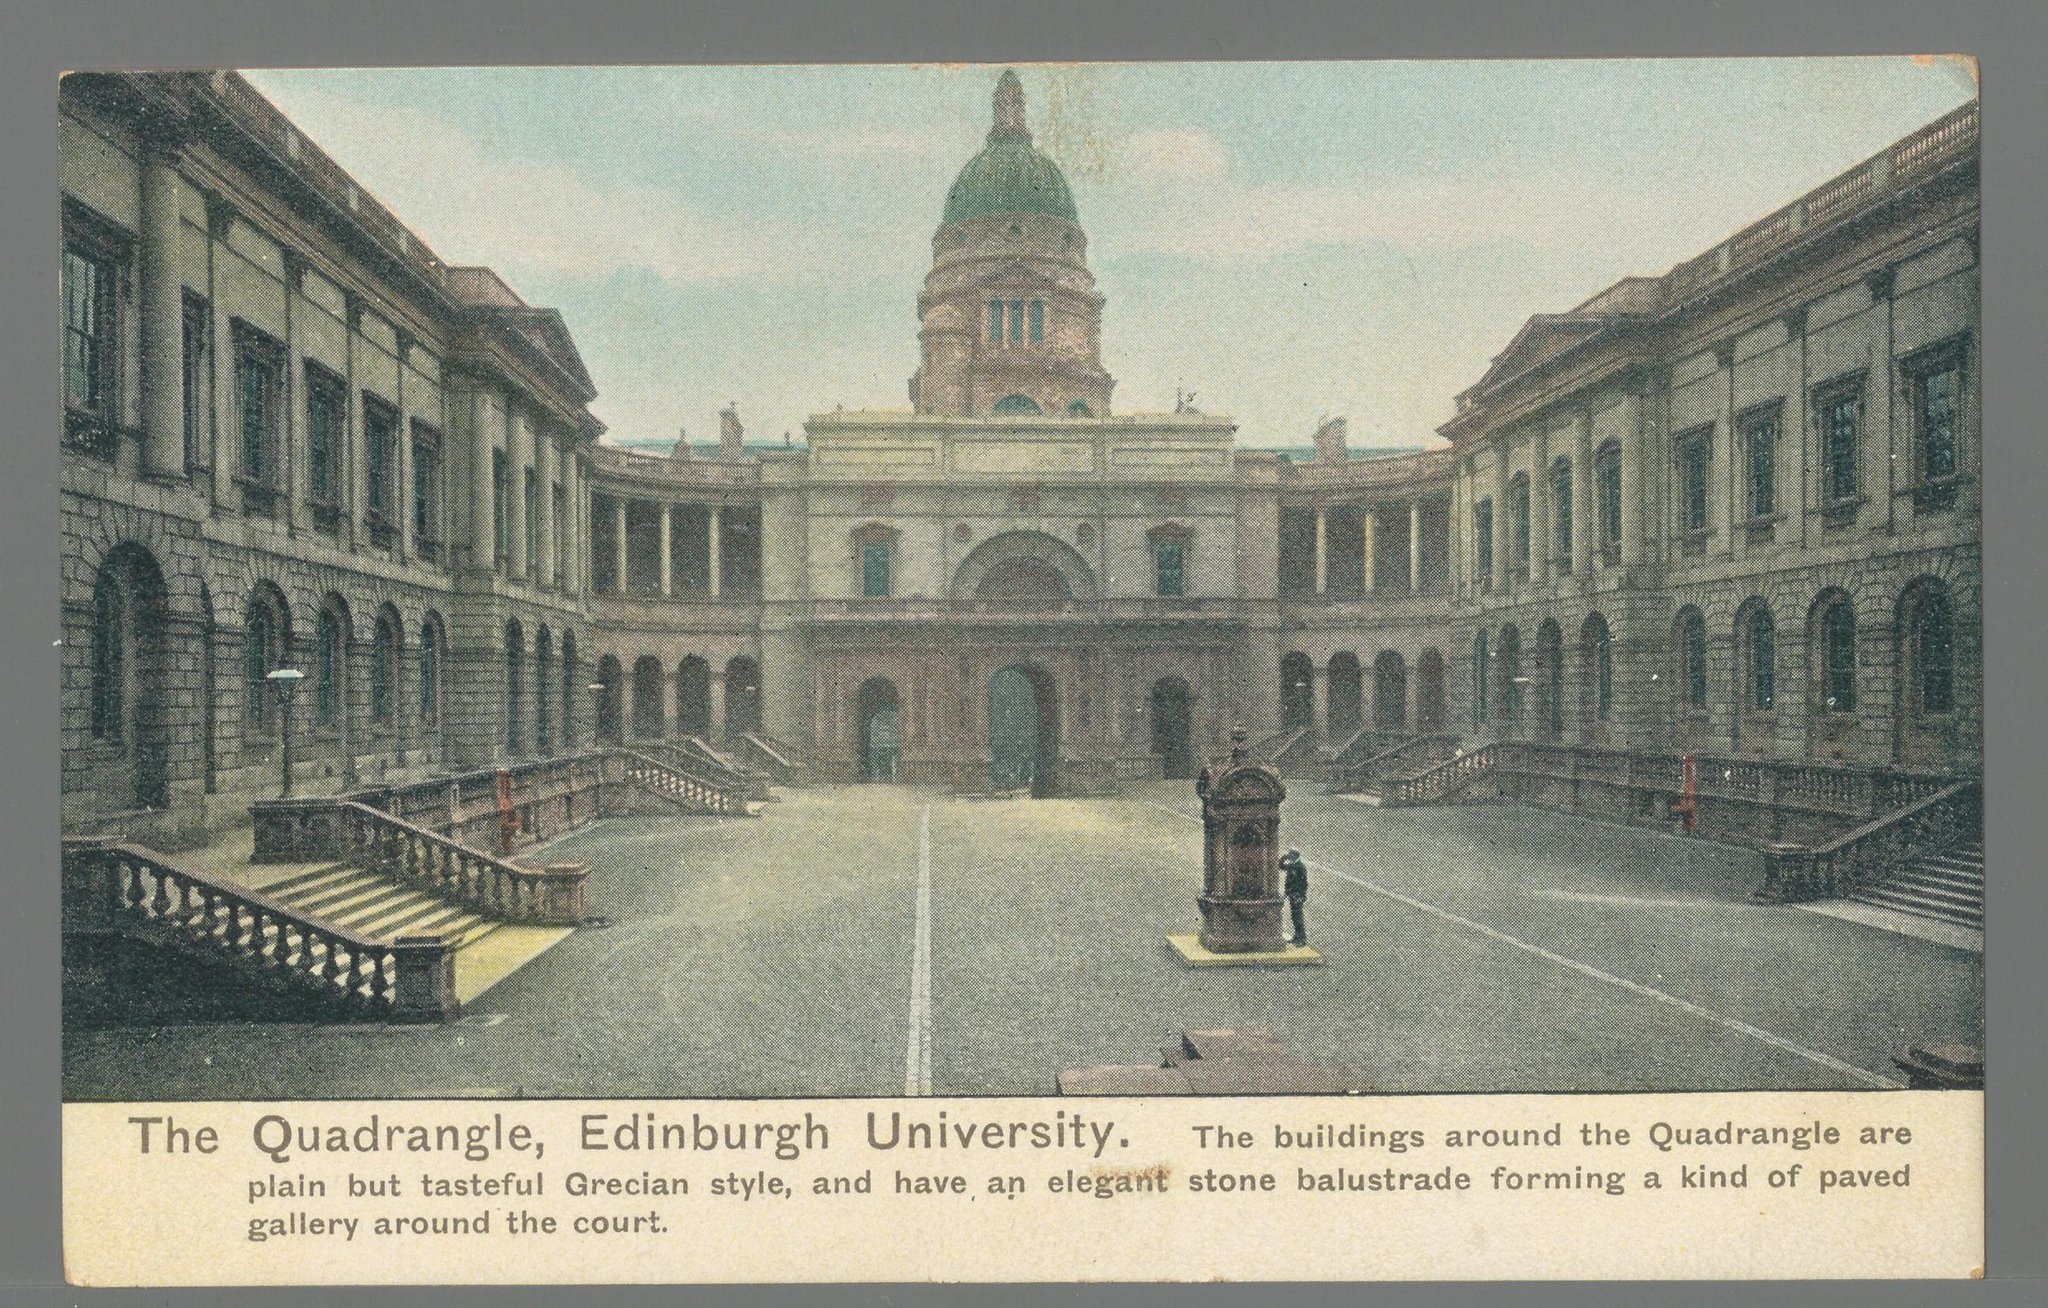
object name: ansichtkaart, prentbriefkaart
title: The Quadrangle, Edinburgh University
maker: Anonymous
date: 1902-1918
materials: cardboard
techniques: lithograph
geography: edinburgh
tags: square, place, circus, etc., university building, college